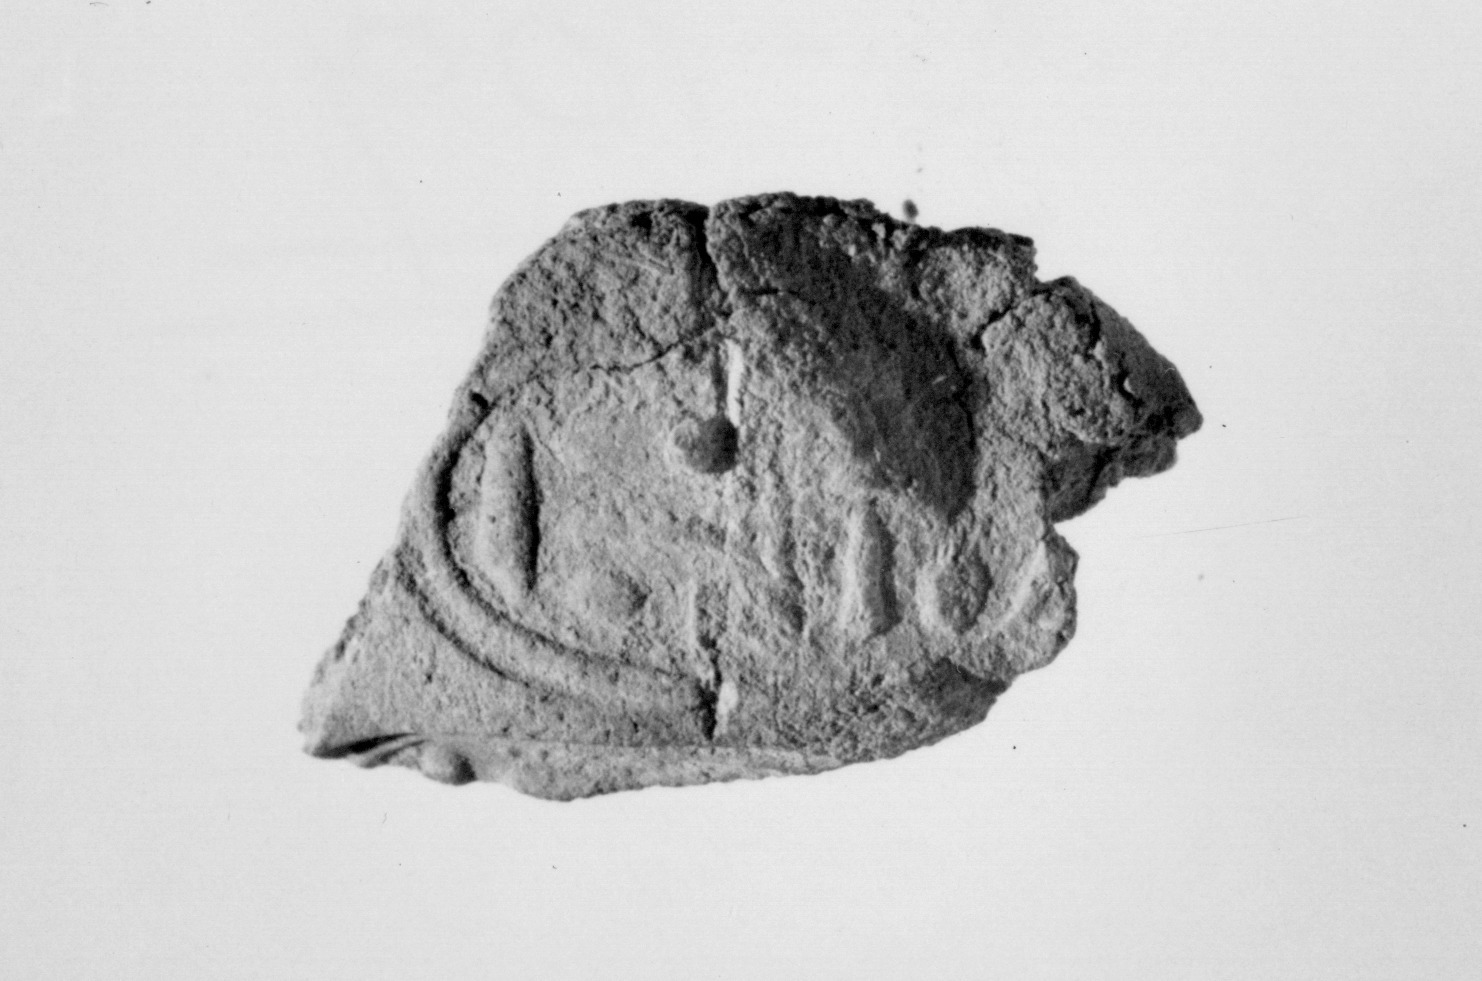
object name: sealing, amun re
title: Document Sealing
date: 1390-1352 BCE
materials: mud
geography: egypt